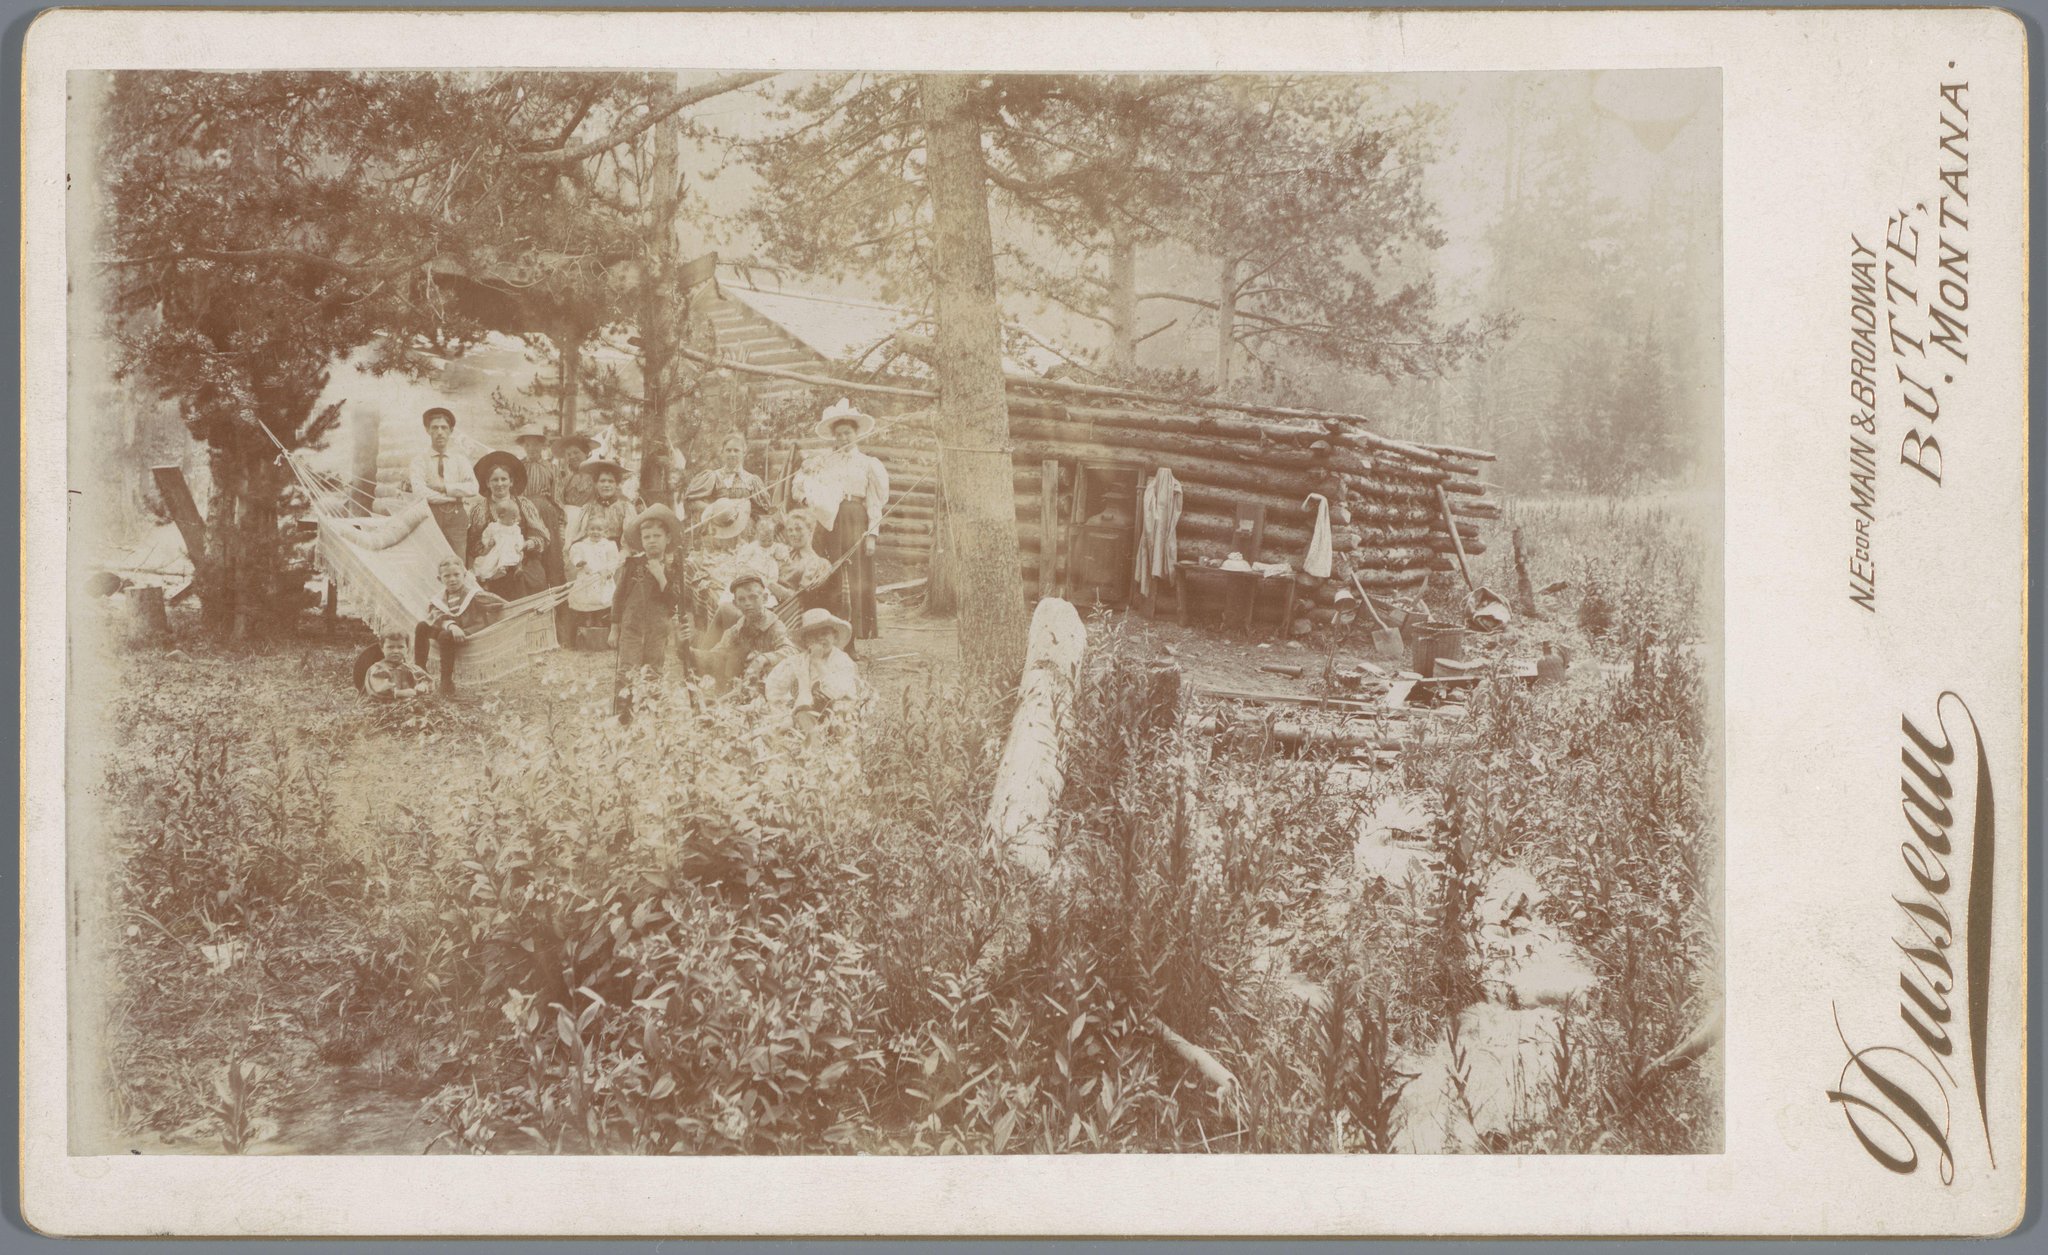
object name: cabinet photograph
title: Familie poseert voor boshut, Butte, Montana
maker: a.j. dusseau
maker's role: fotograaf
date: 1895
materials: photographic support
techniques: collodion silver print